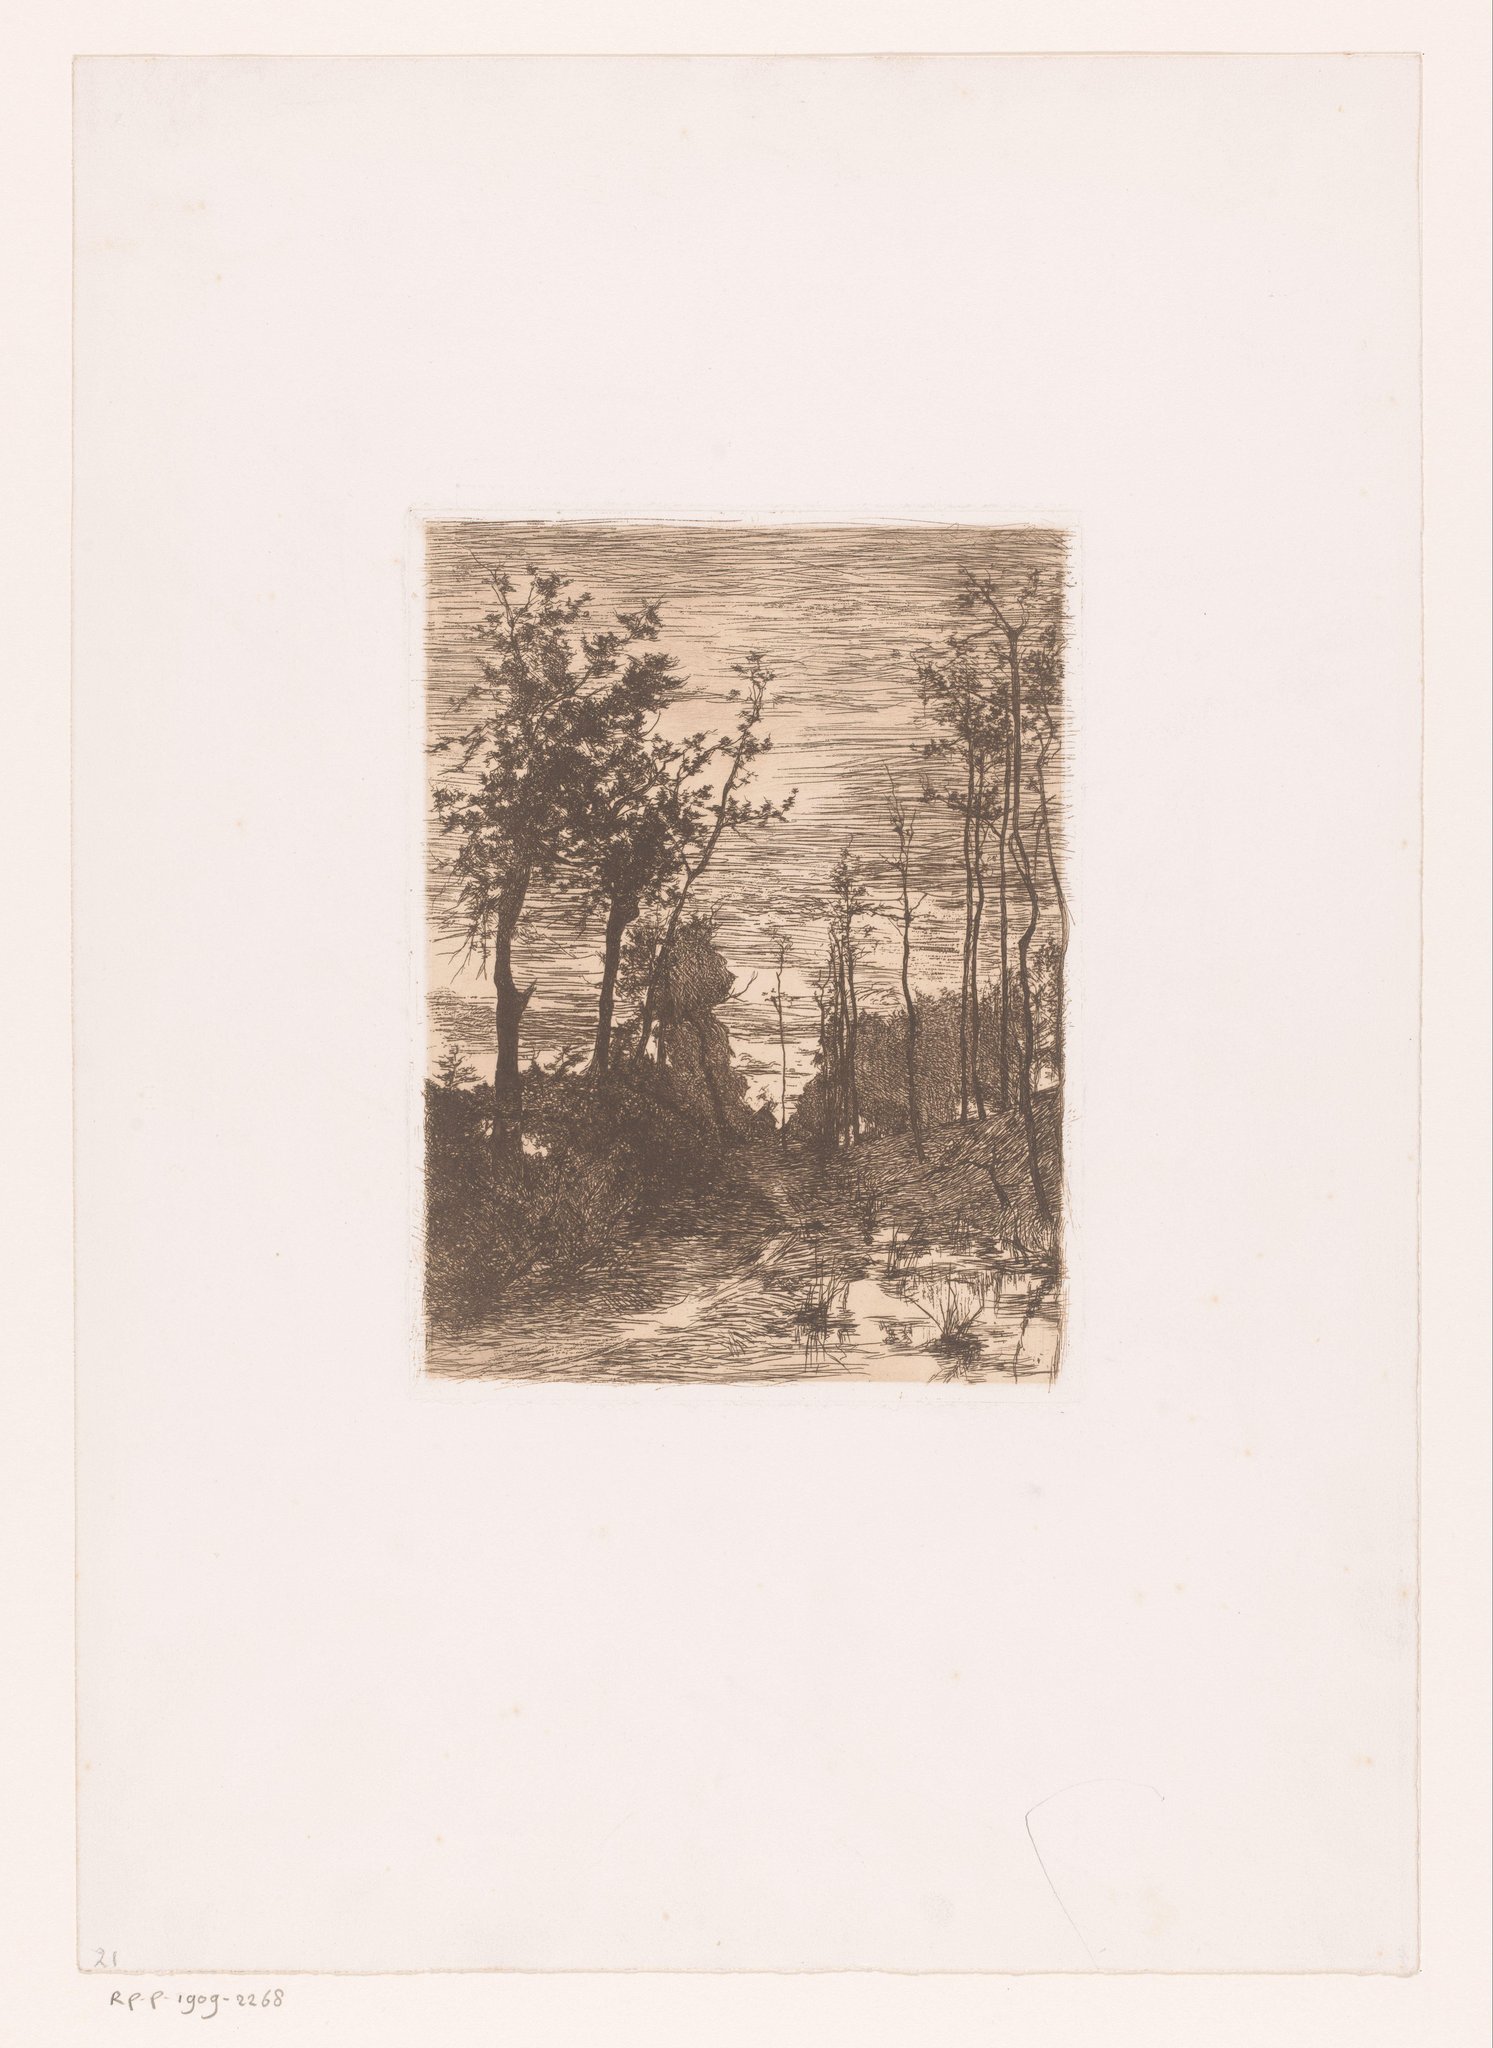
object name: print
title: Landweg tussen smalle bomen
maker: van berg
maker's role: print maker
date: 1850-1909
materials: paper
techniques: etching, intaglio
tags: trees, road, path, mechelen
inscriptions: collector's mark: Lugt 2228